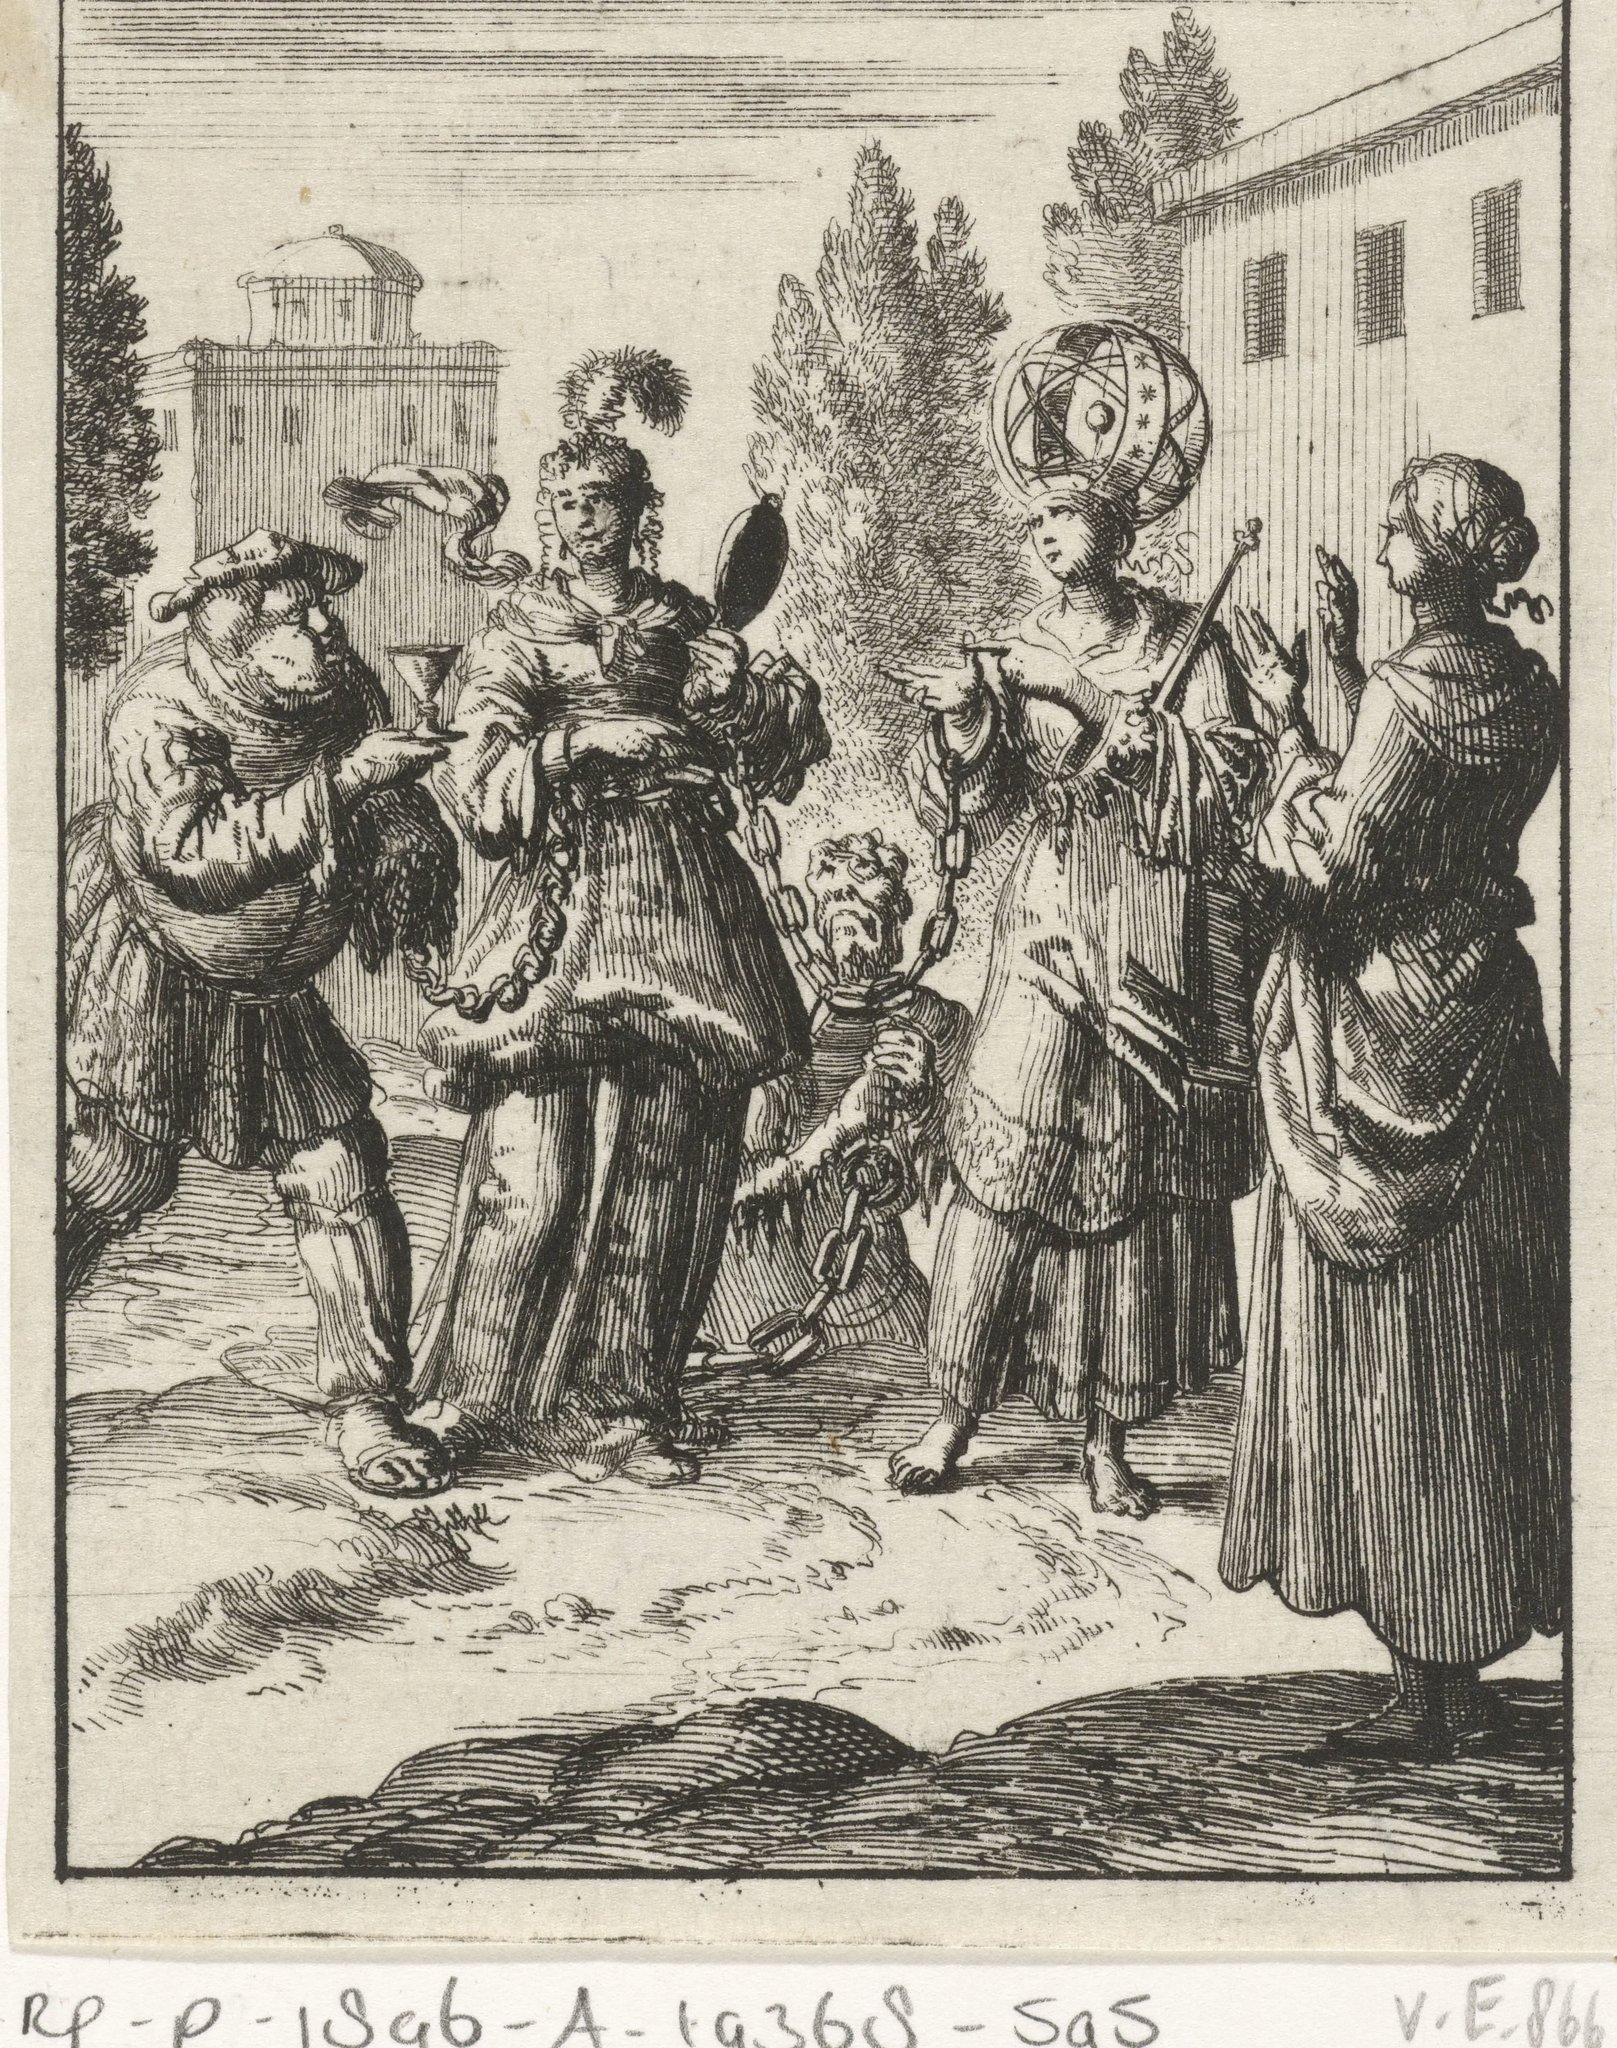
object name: book illustration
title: Vrouw aanschouwt een rijk geklede dame die is vastgeketend aan de Wereld, de Wellust en de Duivel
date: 1687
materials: paper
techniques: etching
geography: amsterdam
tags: lust, luxury, 'luxuria'; 'lussuria' (ripa) ~ personification of one of the deadly sins, devil(s) and demons, 'mondo', 'machina del mondo' (ripa)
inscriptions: collector's mark: Lugt 2228, number: ‘31’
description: Illustratie uit: Luyken, Jan. Voncken der liefde Jesu, van het godtbegerende zielenvier. Amsterdam: Pieter Arentsz (II), 1687, p. 128.